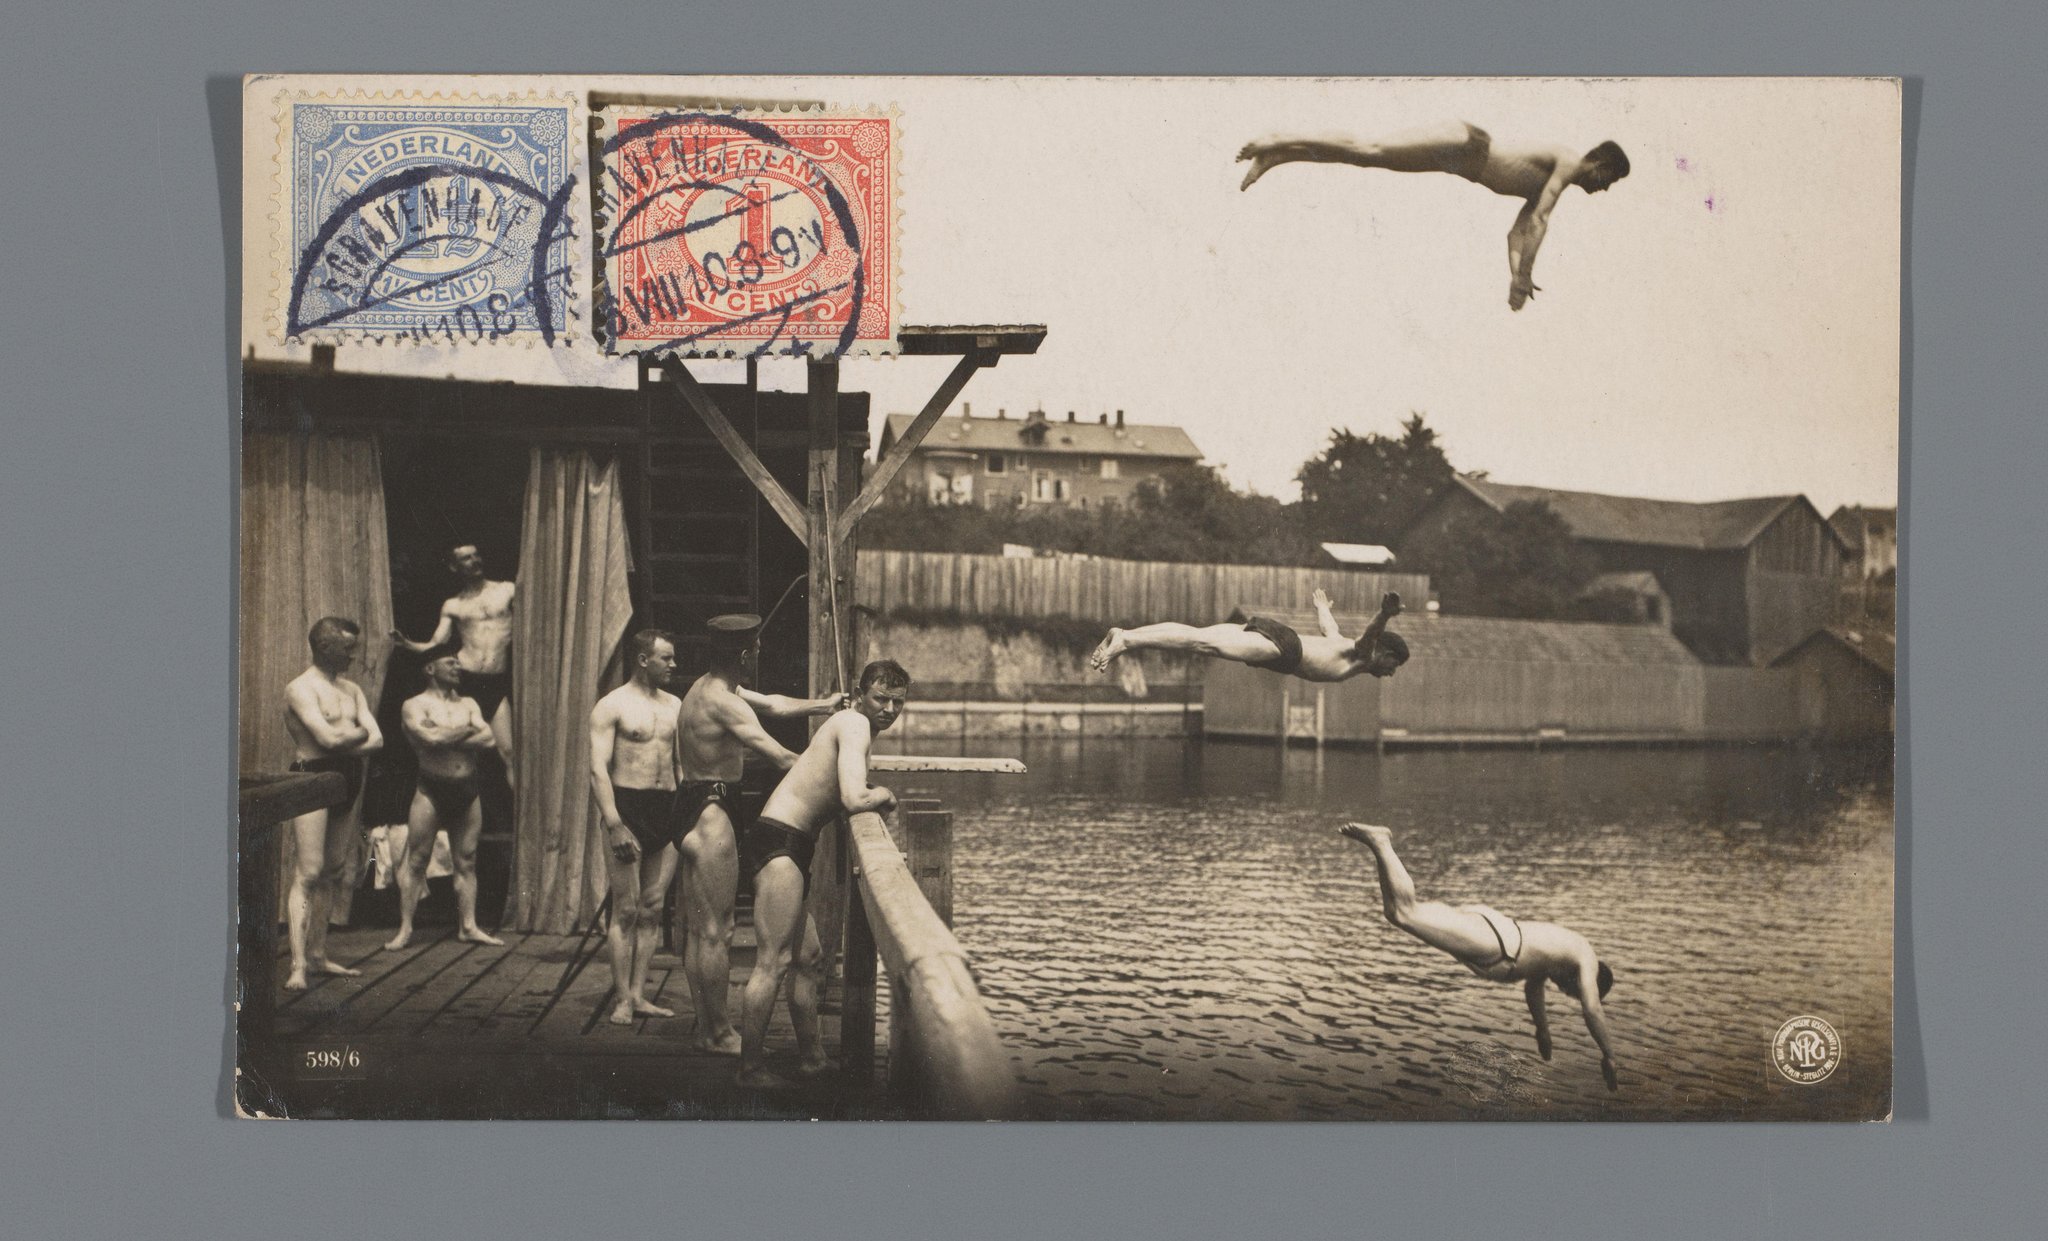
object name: ansichtkaart, prentbriefkaart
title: Duikende mannen in zwembad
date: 1910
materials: cardboard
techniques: gelatin silver print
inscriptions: stamp: ‘drukwerk’, stamp: ‘poststempel Den Haag (waarschijnlijk 1910) en handgeschreven tekst’